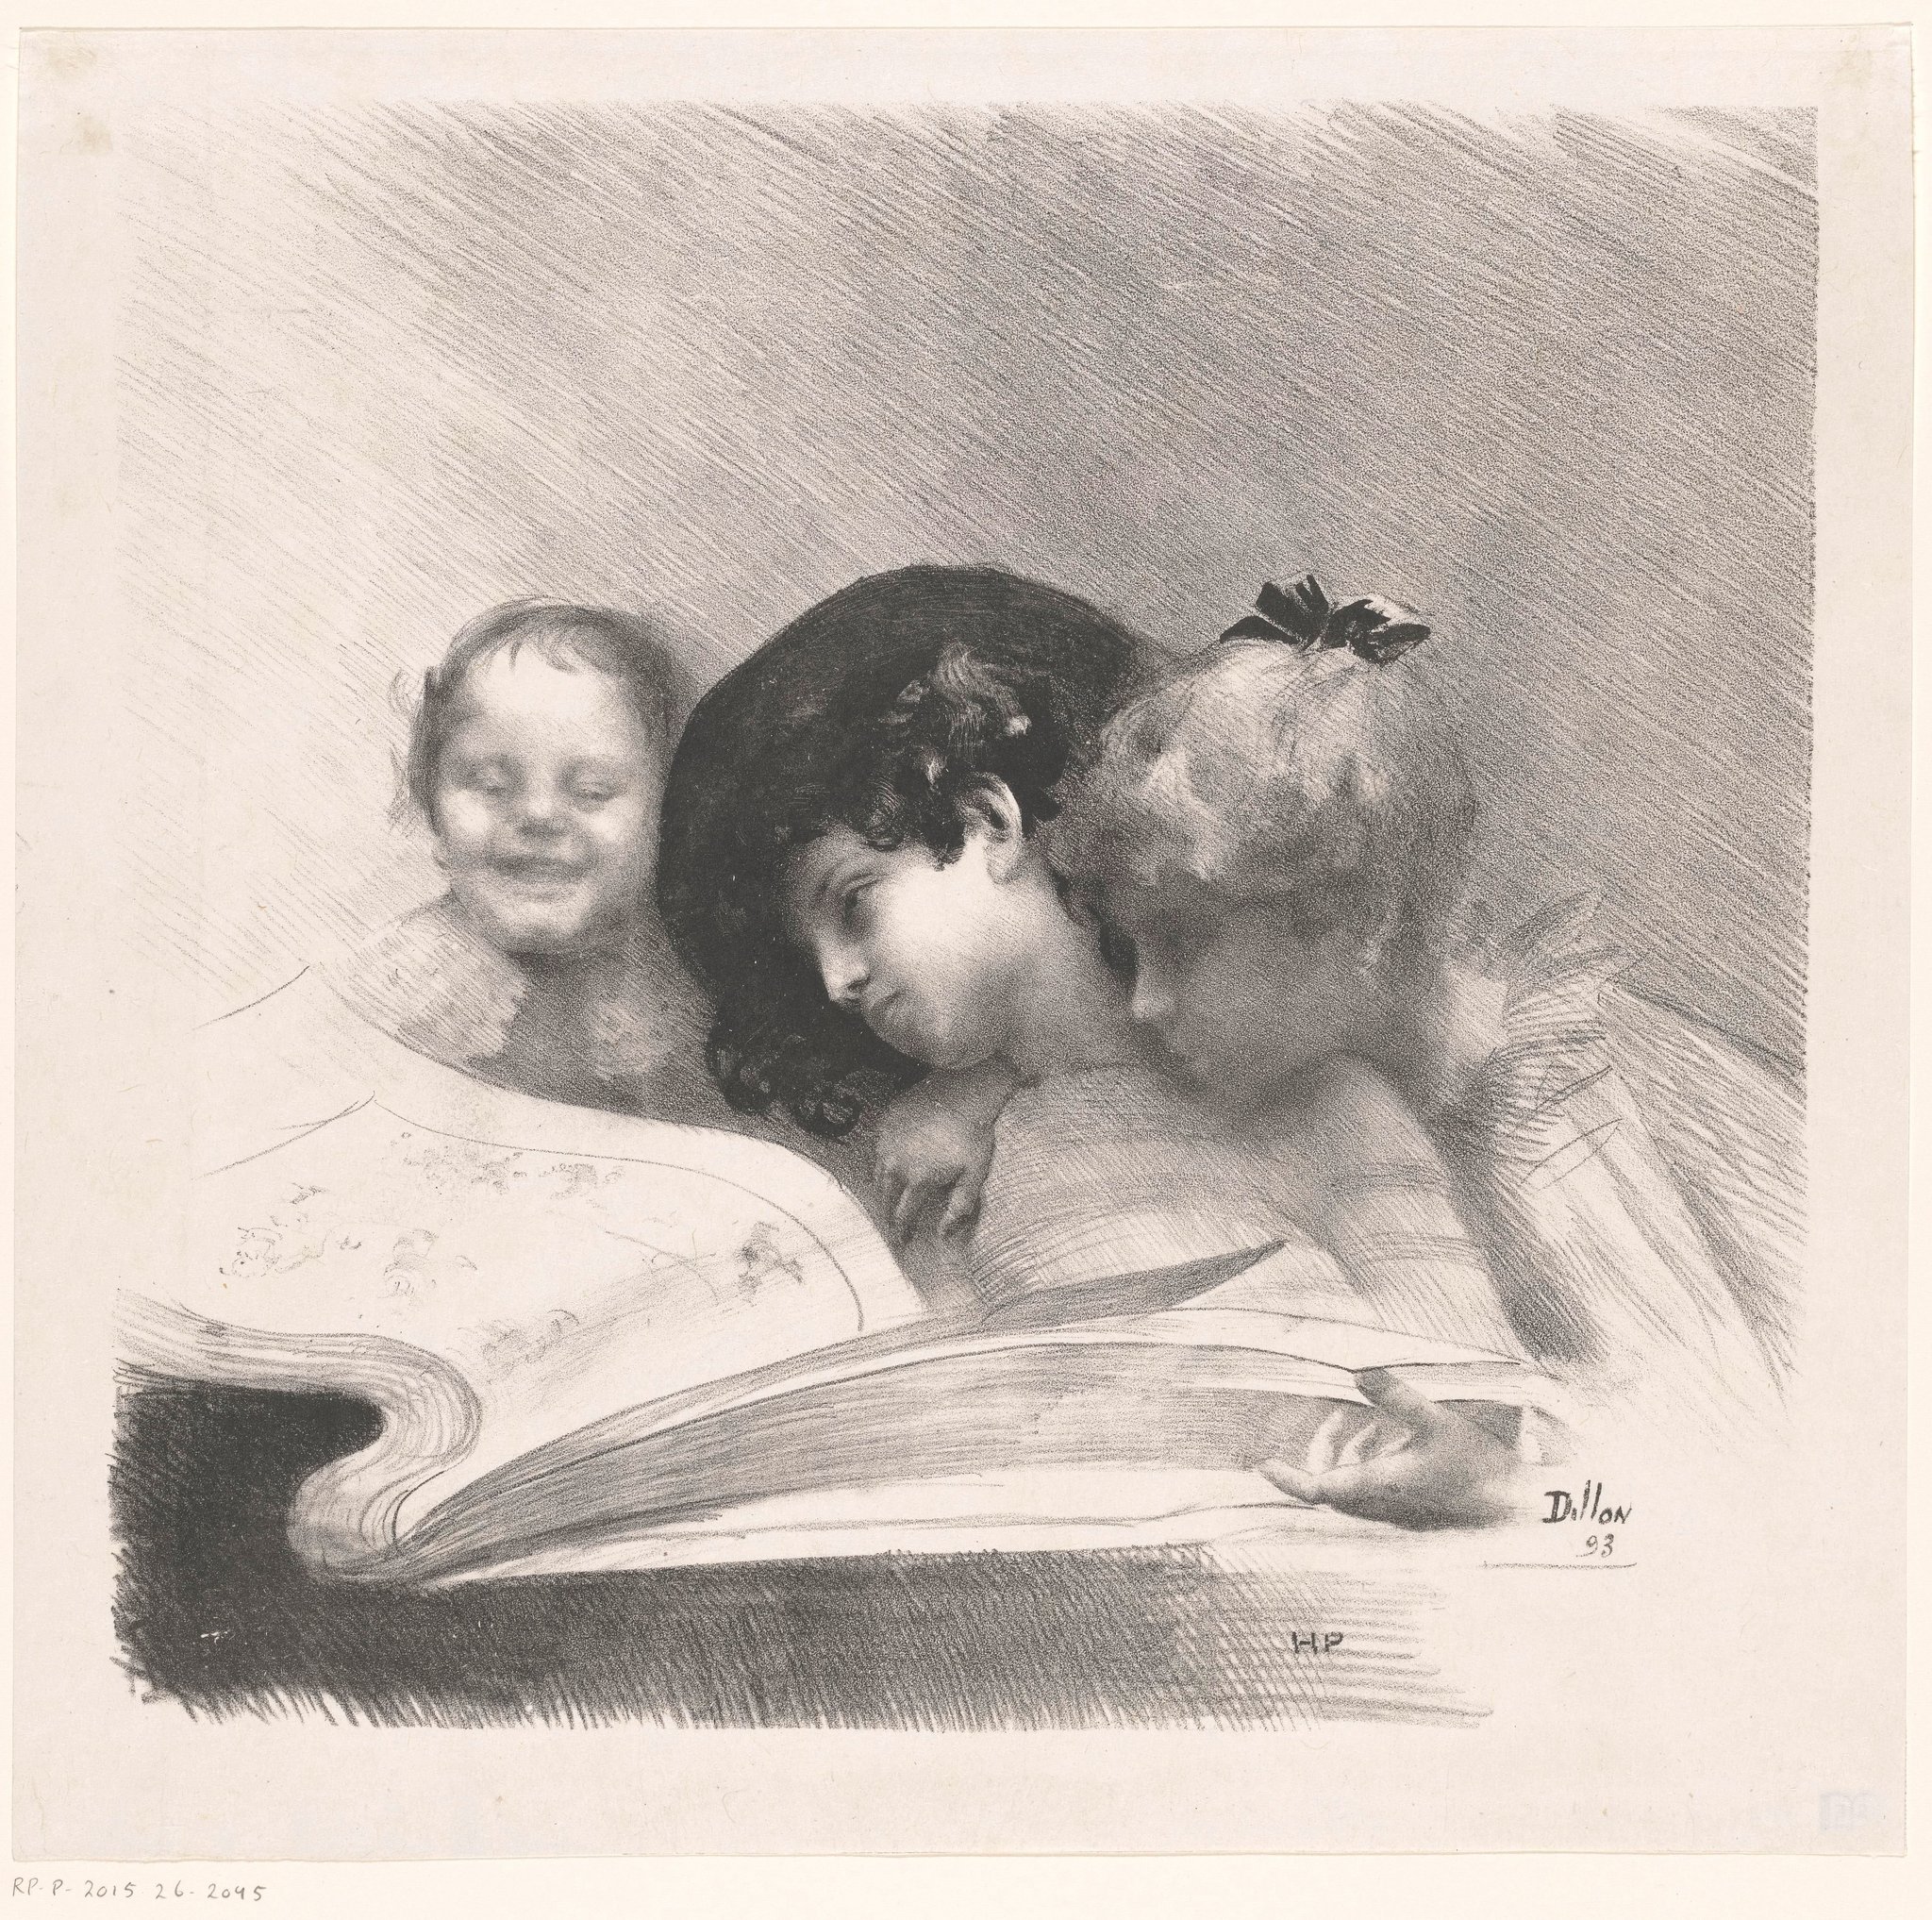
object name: print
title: Drie meisjes bekijken een prentalbum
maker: henri patrice dillon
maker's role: print maker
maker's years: 1850-1909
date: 1893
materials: paper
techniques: lithograph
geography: france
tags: print, e.g.: engraving, etching, lithograph, book in which illustrations are essential - mm - book open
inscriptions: collector's mark: Lugt 4779